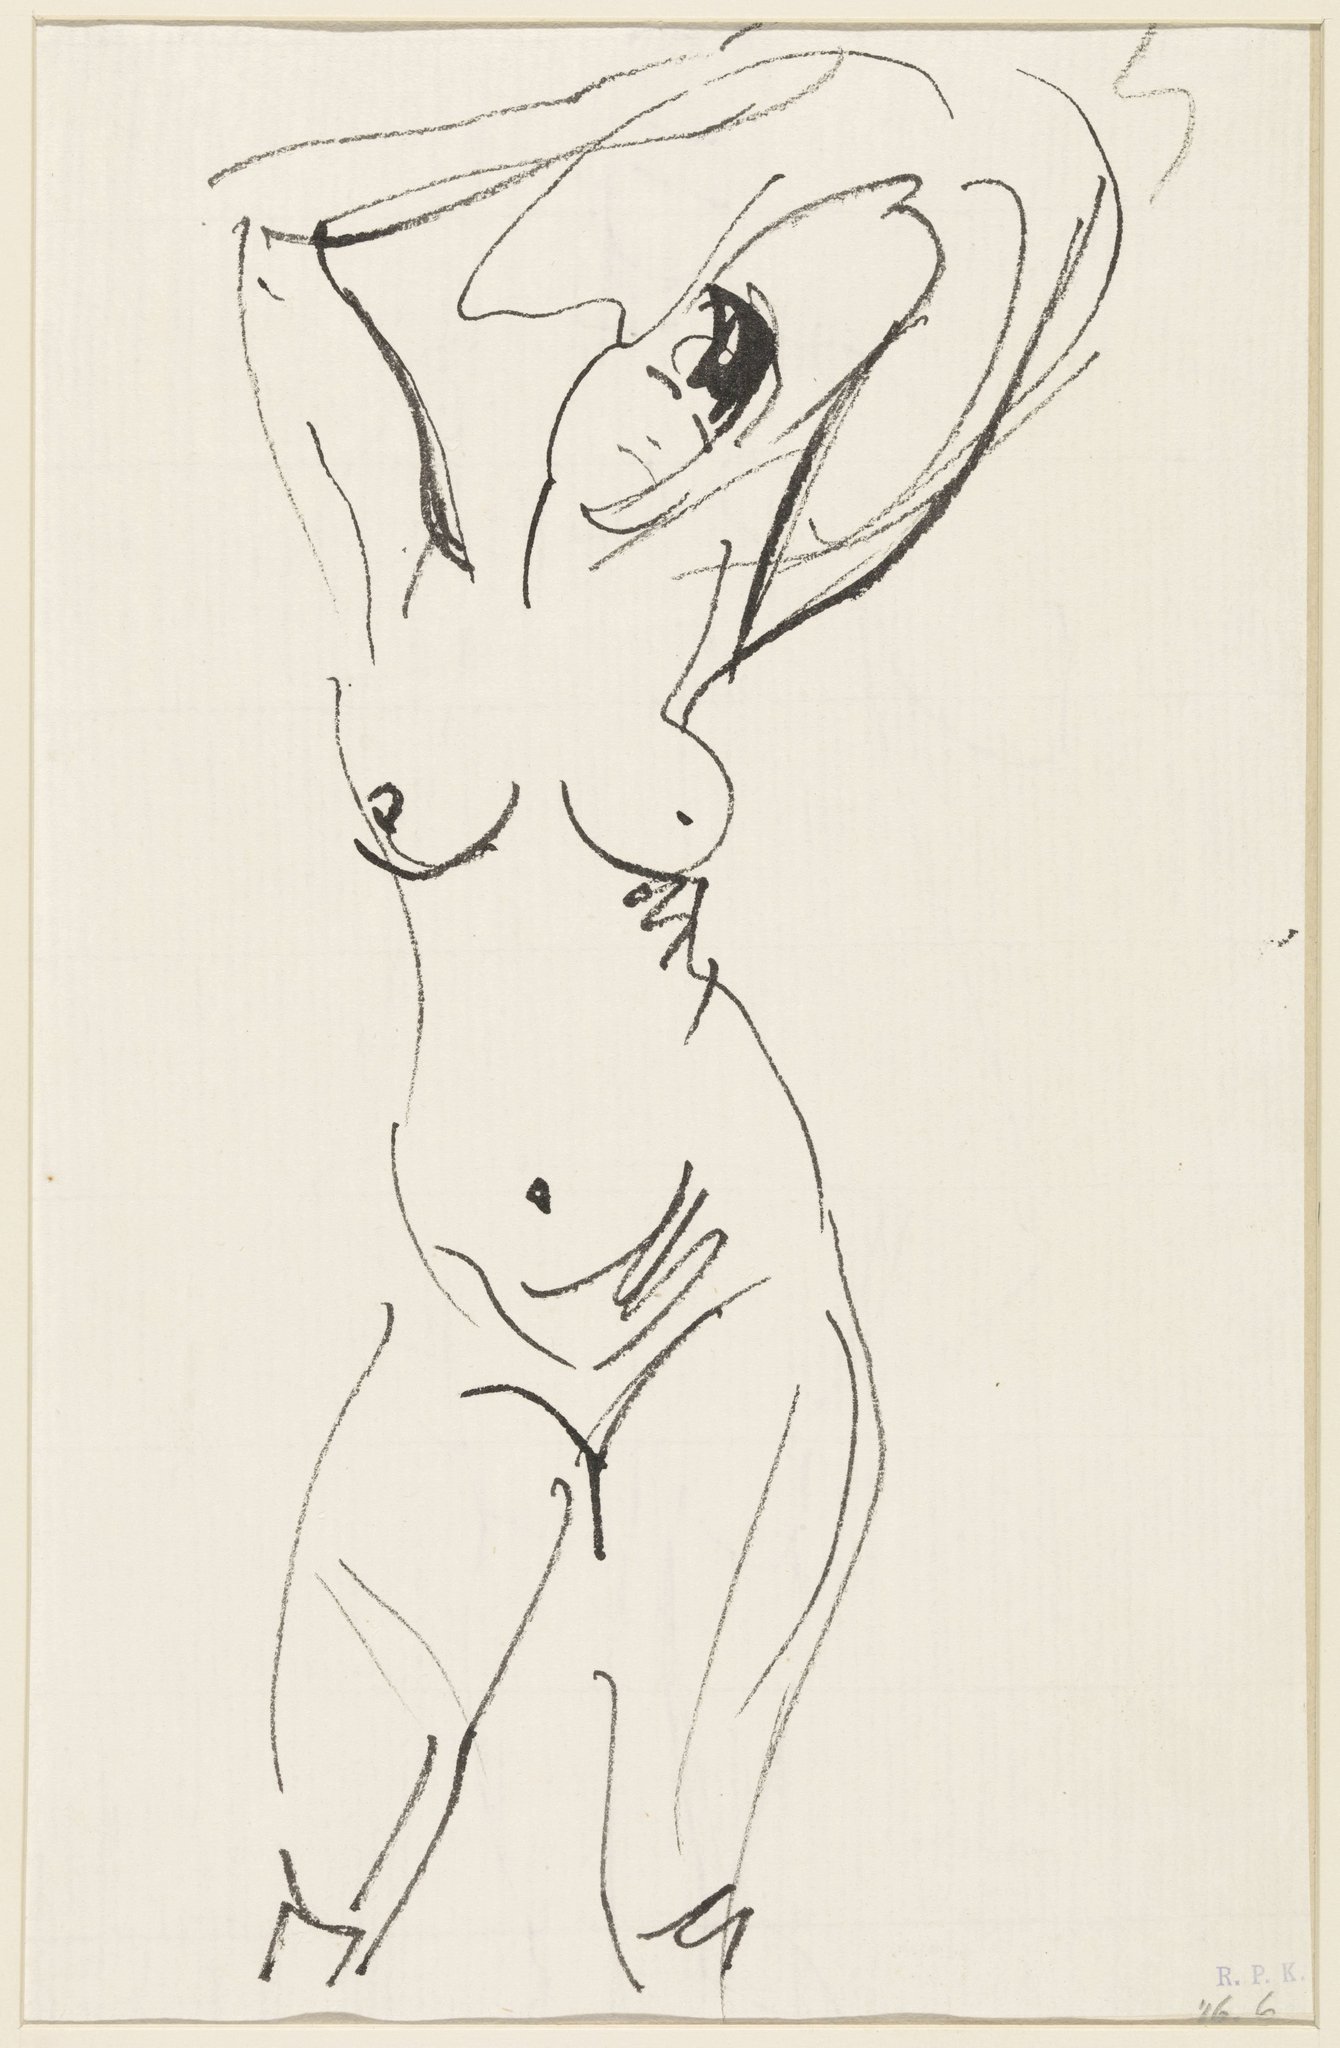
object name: drawing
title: Standing Female Nude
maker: rik wouters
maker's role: draughtsman, print maker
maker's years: 1882-1916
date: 1892-1916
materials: ink, paper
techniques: pen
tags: standing figure - aa - female human figure